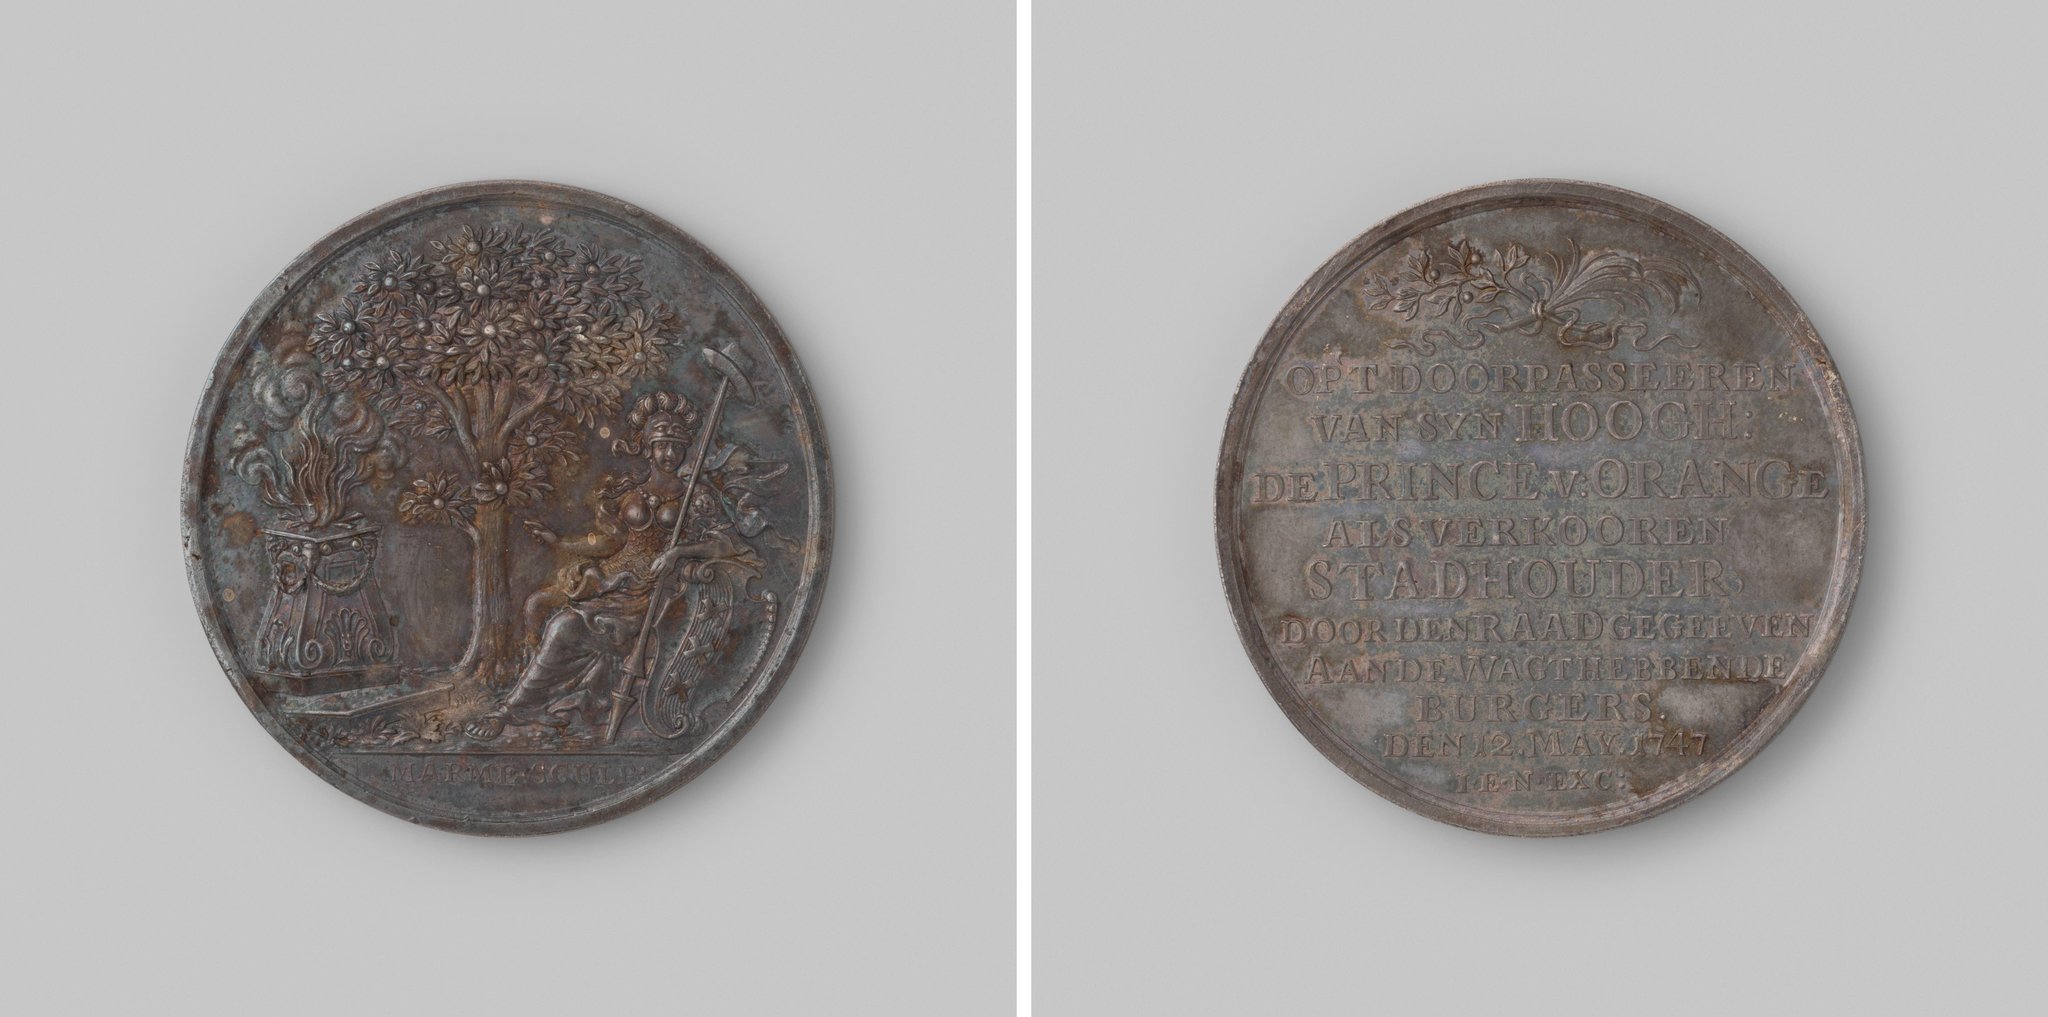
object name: history medal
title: Gedenkpenning vereerd aan de wachthebbende burgers van Amsterdam, ter herinnering aan het verblijf van Prins Willem IV te Amsterdam op 11 en 12 mei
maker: johann conrad marmé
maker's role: die cutter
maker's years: 1710-1772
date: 1747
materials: silver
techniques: striking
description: Zilveren penning, 1e grootte. Op last van de Amsterdamse regering uitgereikt aan de hoofdofficieren. Voorzijde: Amsterdamse stedemaagd in de gedaante van Minerva met borstharnas en helm met pluim, zittende naast een oranjeboom vol vruchten waarheen zij wijst, terwijl zij met de linkerarm op het stadswapen rust en een lans vasthoudt met de vrijheidshoed op de punt. Verder een brandend altaar, toespeling op het brengen van een offer voor het verkregen voorrecht dat vrijheid en godsdienst verzekerd waren nu de Prins tot stadhouder gekozen was. Afsnede met naam van de maker: MARME SCULPS(it). Keerzijde: kruislings een oranje- en een palmtak verbonden met een lint, waaronder: OP 'T DOORPASSEEREN/ VAN SYN HOOGH:(eit) DE PRINCE V:(an) ORANGE/ ALS VERKOOREN STADHOUDER,/ DOOR DEN RAAD GEGEEVEN/ AAN DE WAGTHEBBENDE BURGERS/ DEN 12 MAY 1747. Afsnede met voorletters van de graveur: I E N EXC:(udit).